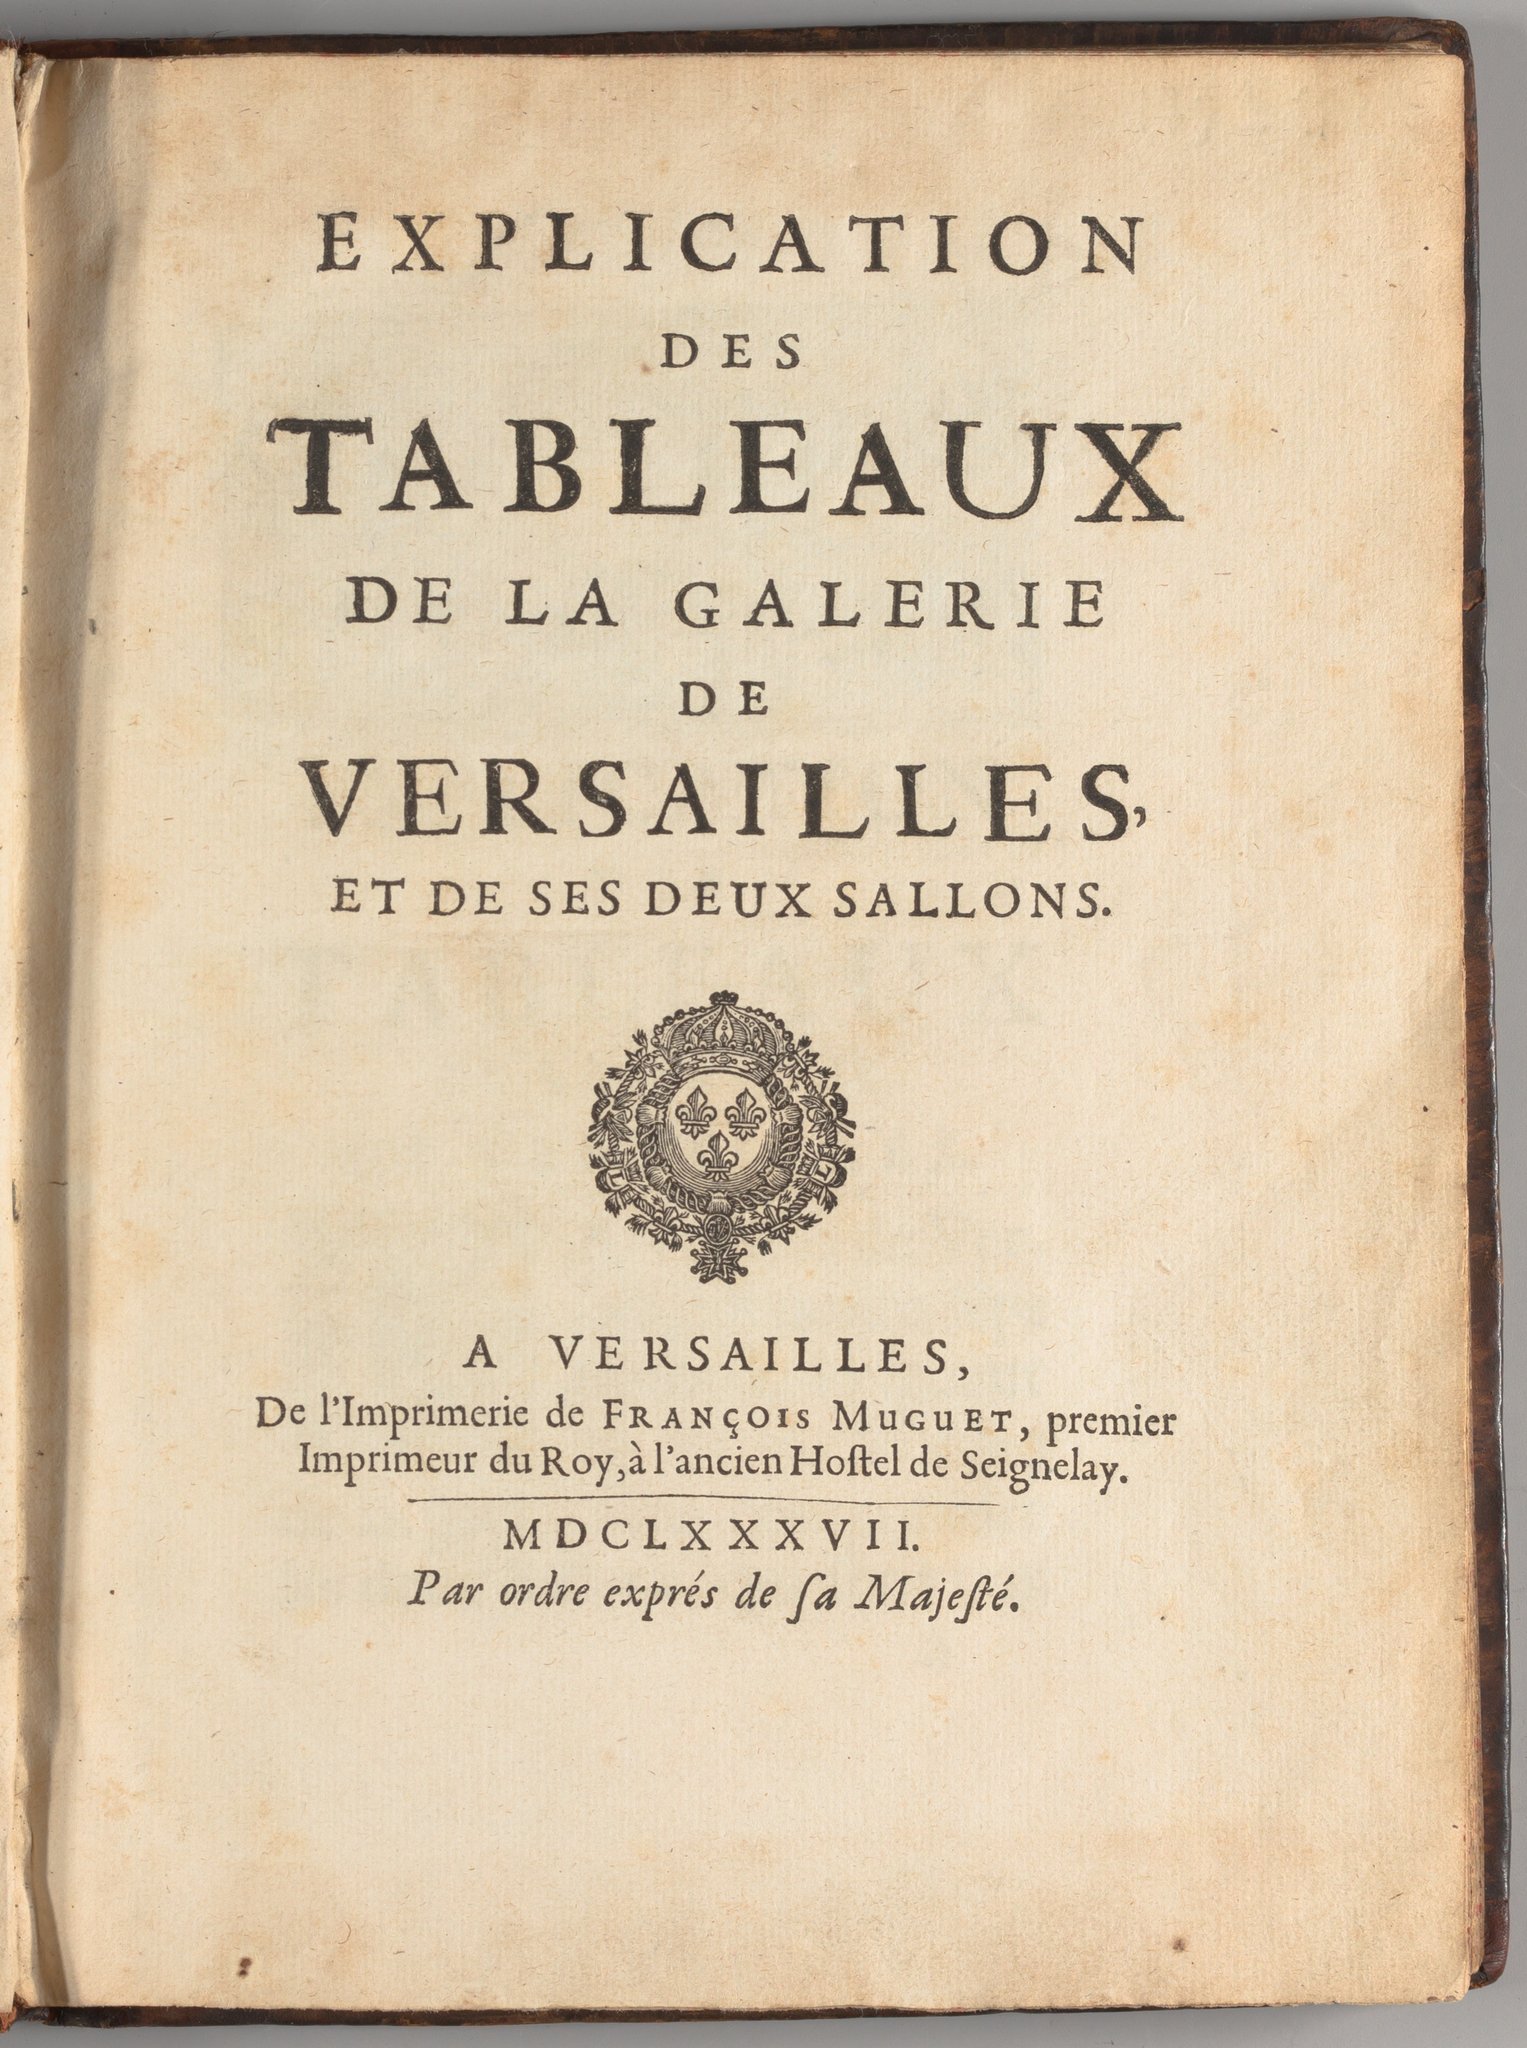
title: Explication des tableaux de la galerie de Versailles, et de ses deux sallons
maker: pierre rainssant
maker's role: author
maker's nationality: french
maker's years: 1640-1689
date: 1687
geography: france